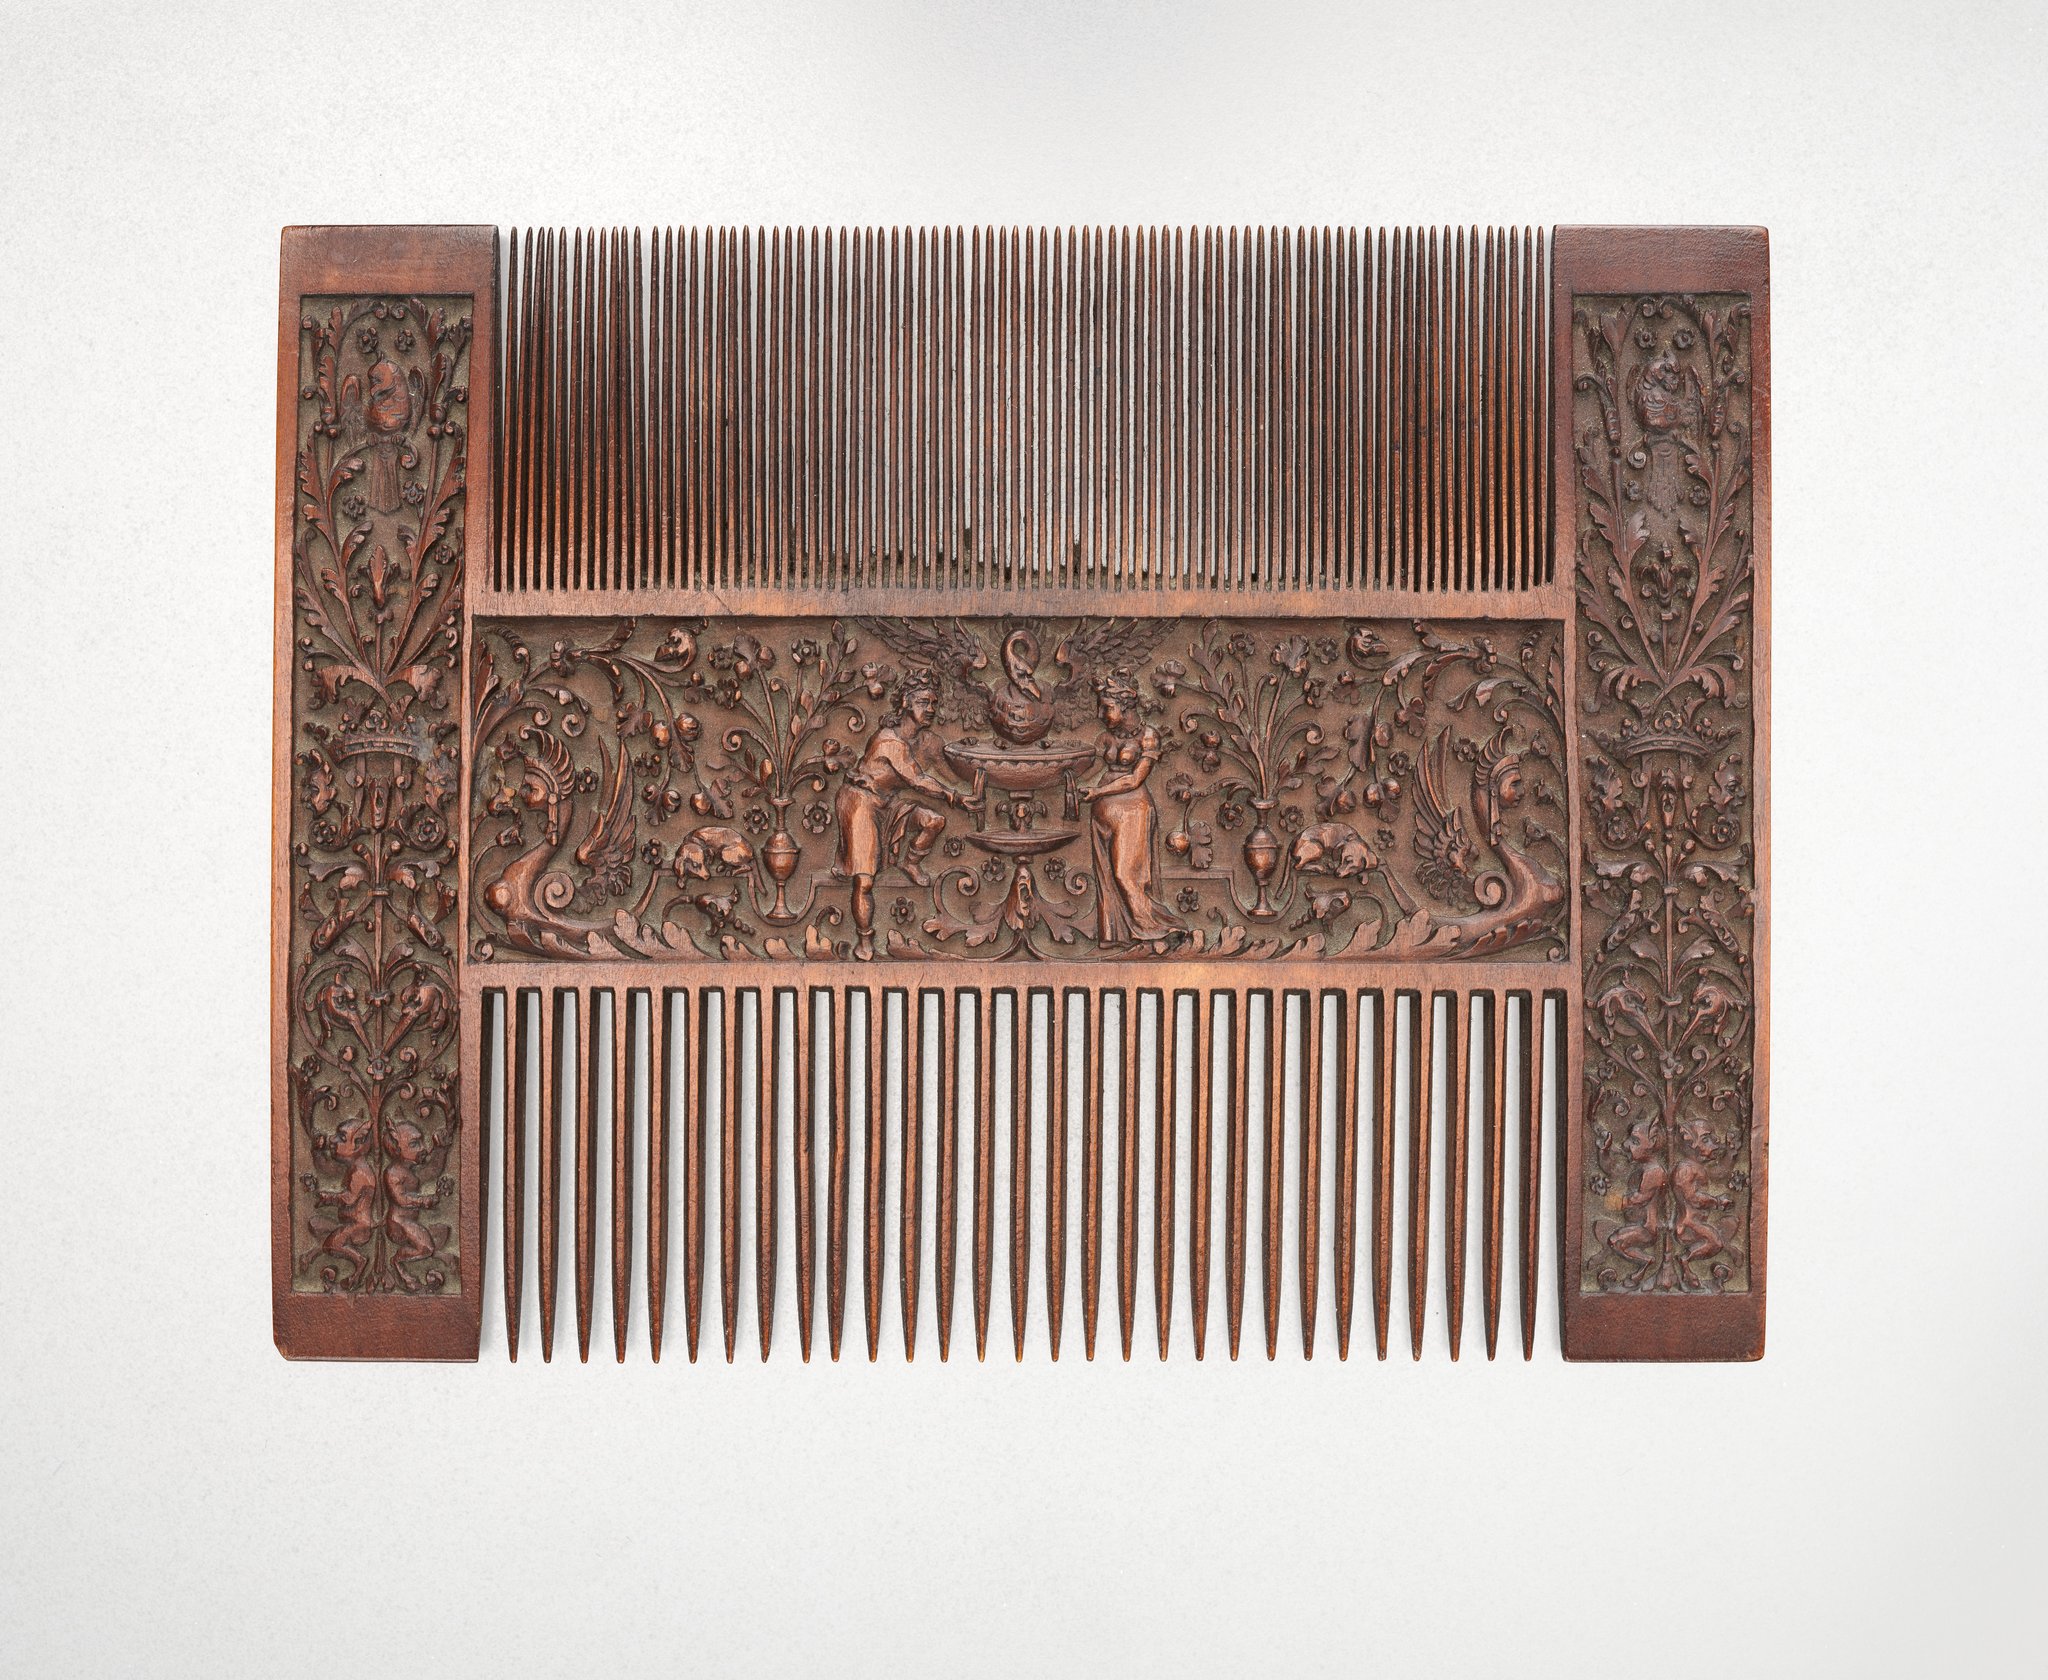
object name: comb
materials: wood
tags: fountains,men,women